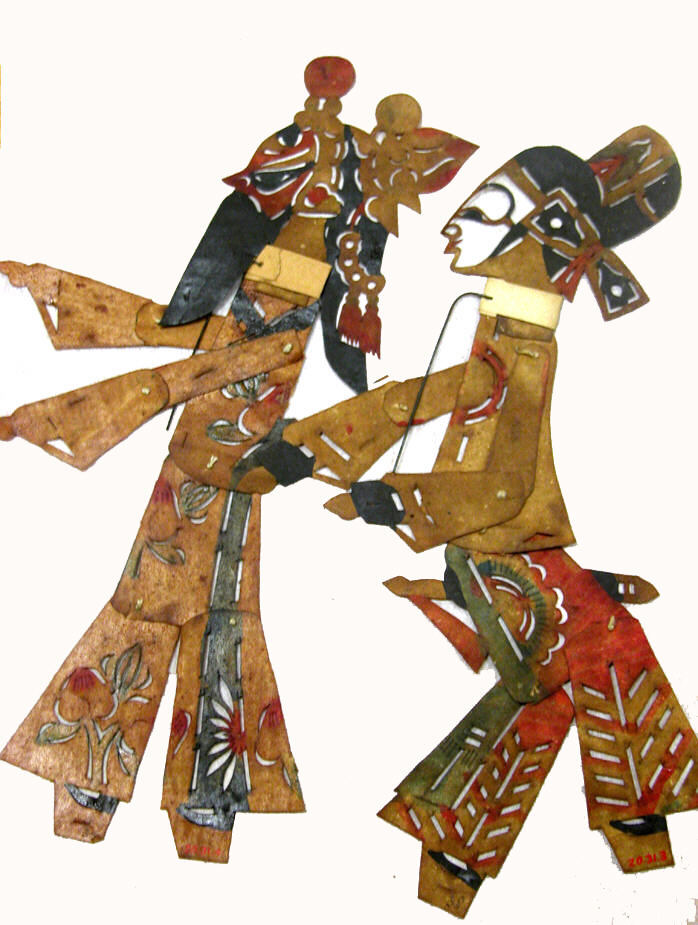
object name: shadow player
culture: chinese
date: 1801-1900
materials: cord, skin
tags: swords,women